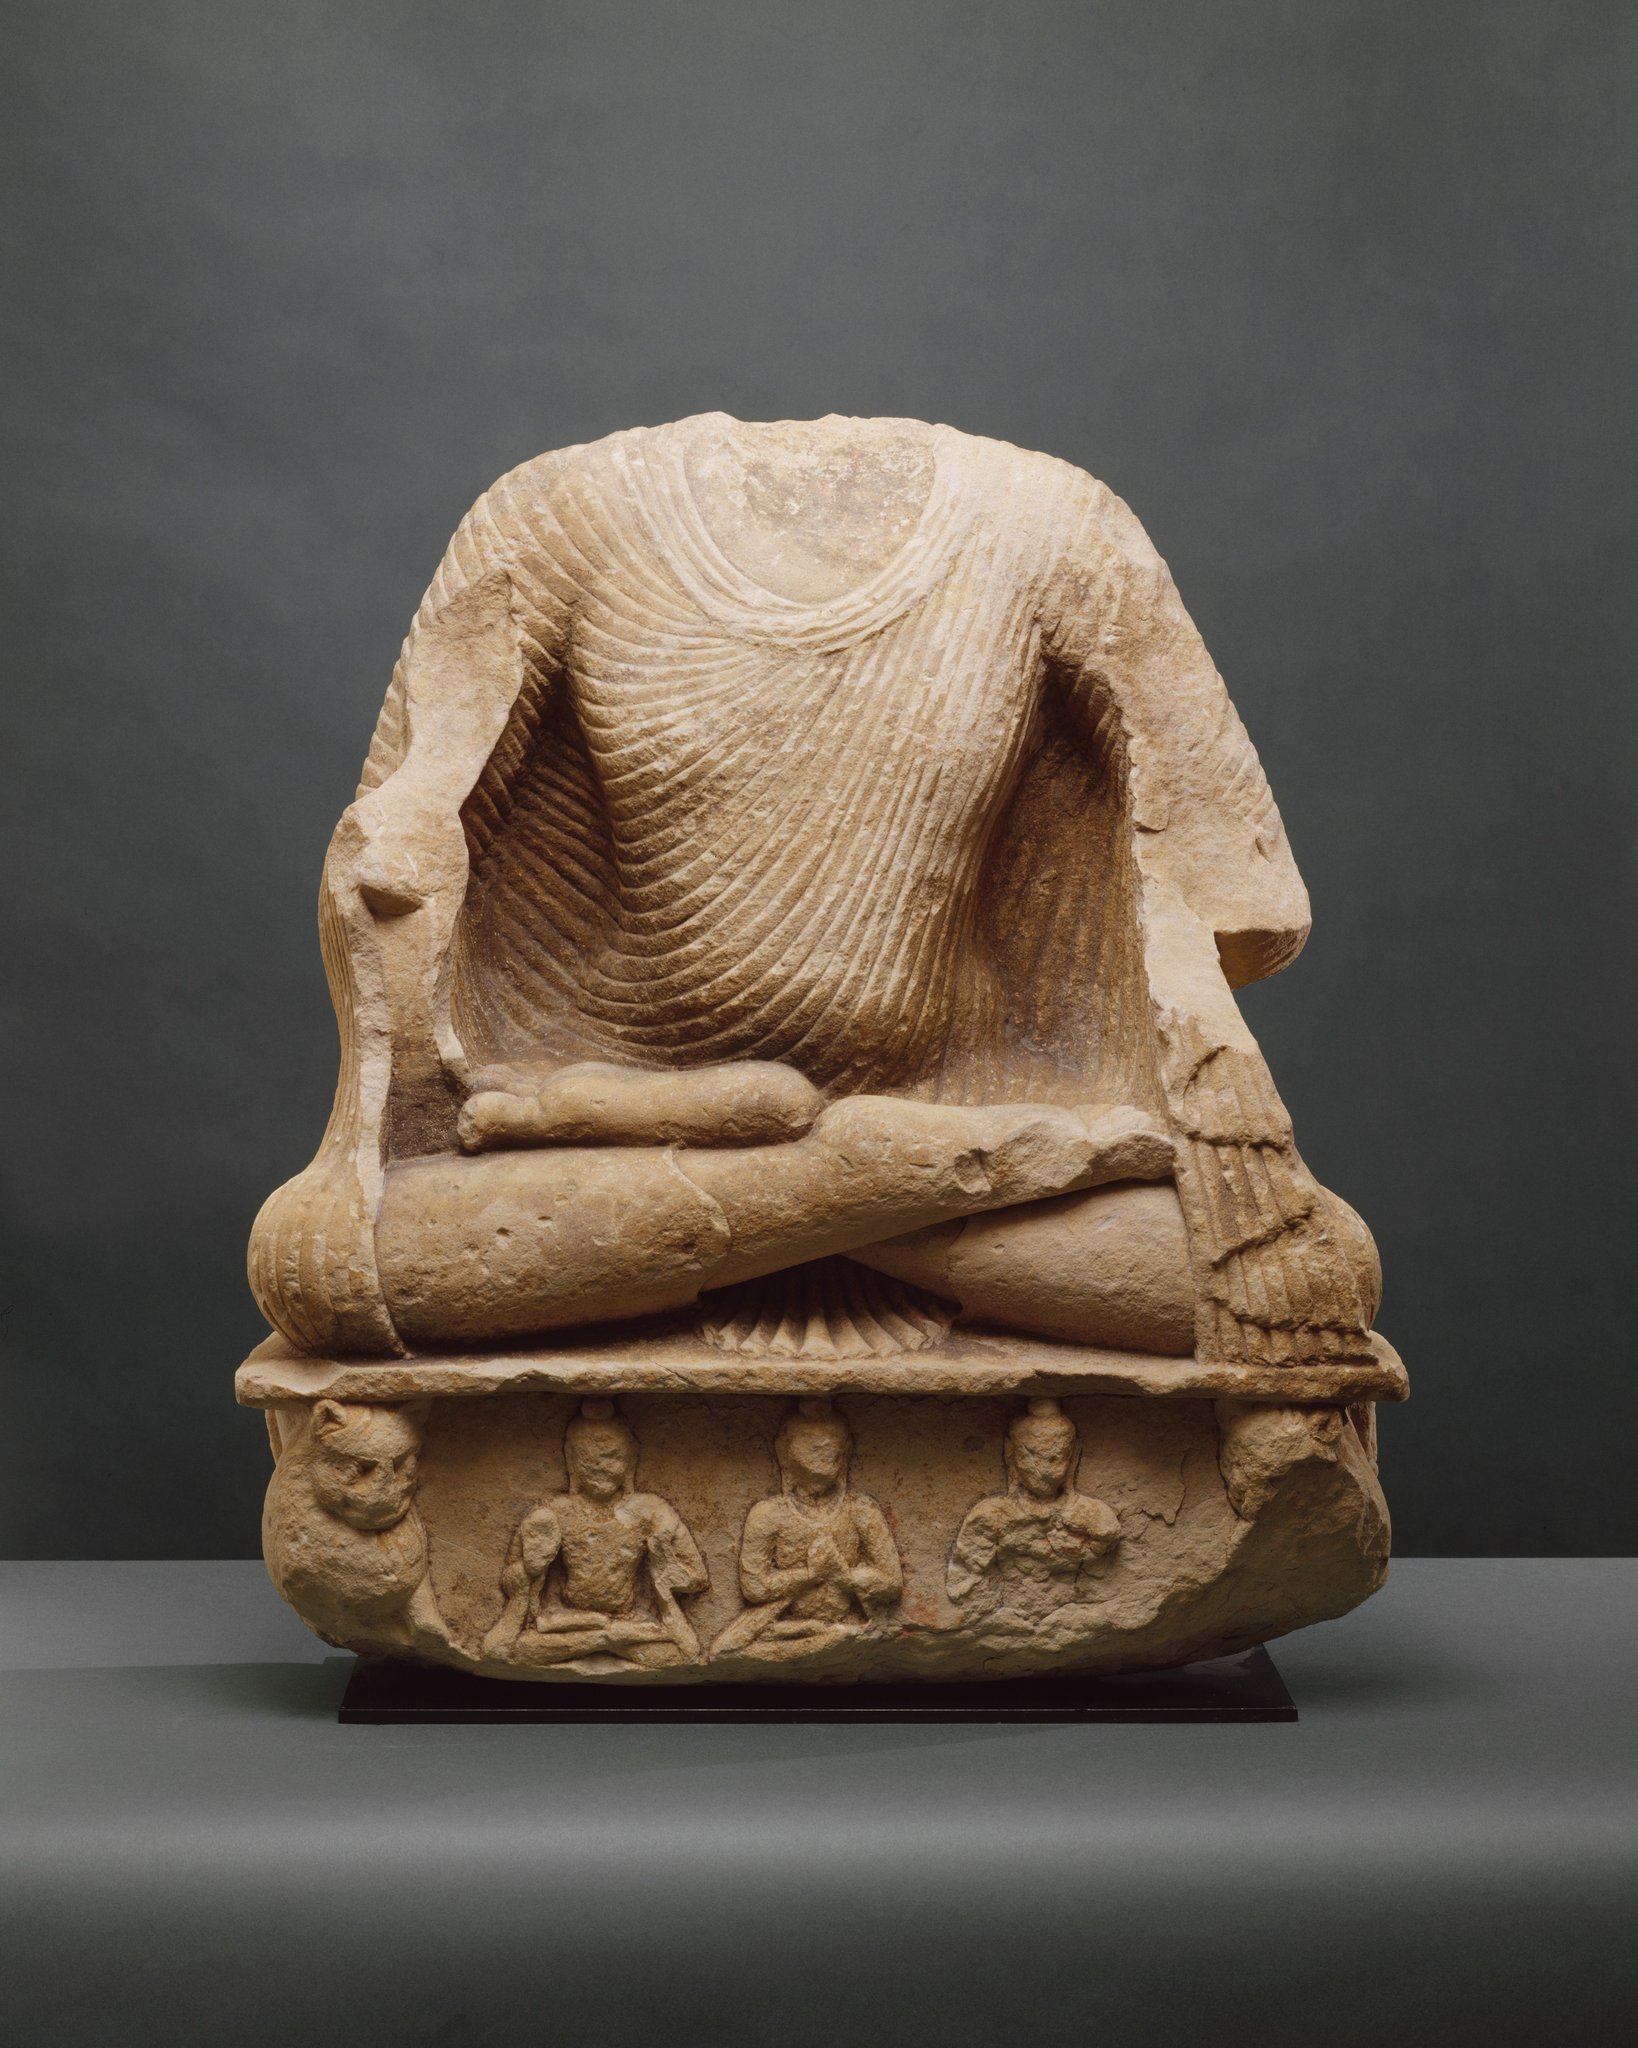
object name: headless figure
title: Seated Buddha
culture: indian, uttar pradesh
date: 401-425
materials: stone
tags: gupta,buddhism,buddha